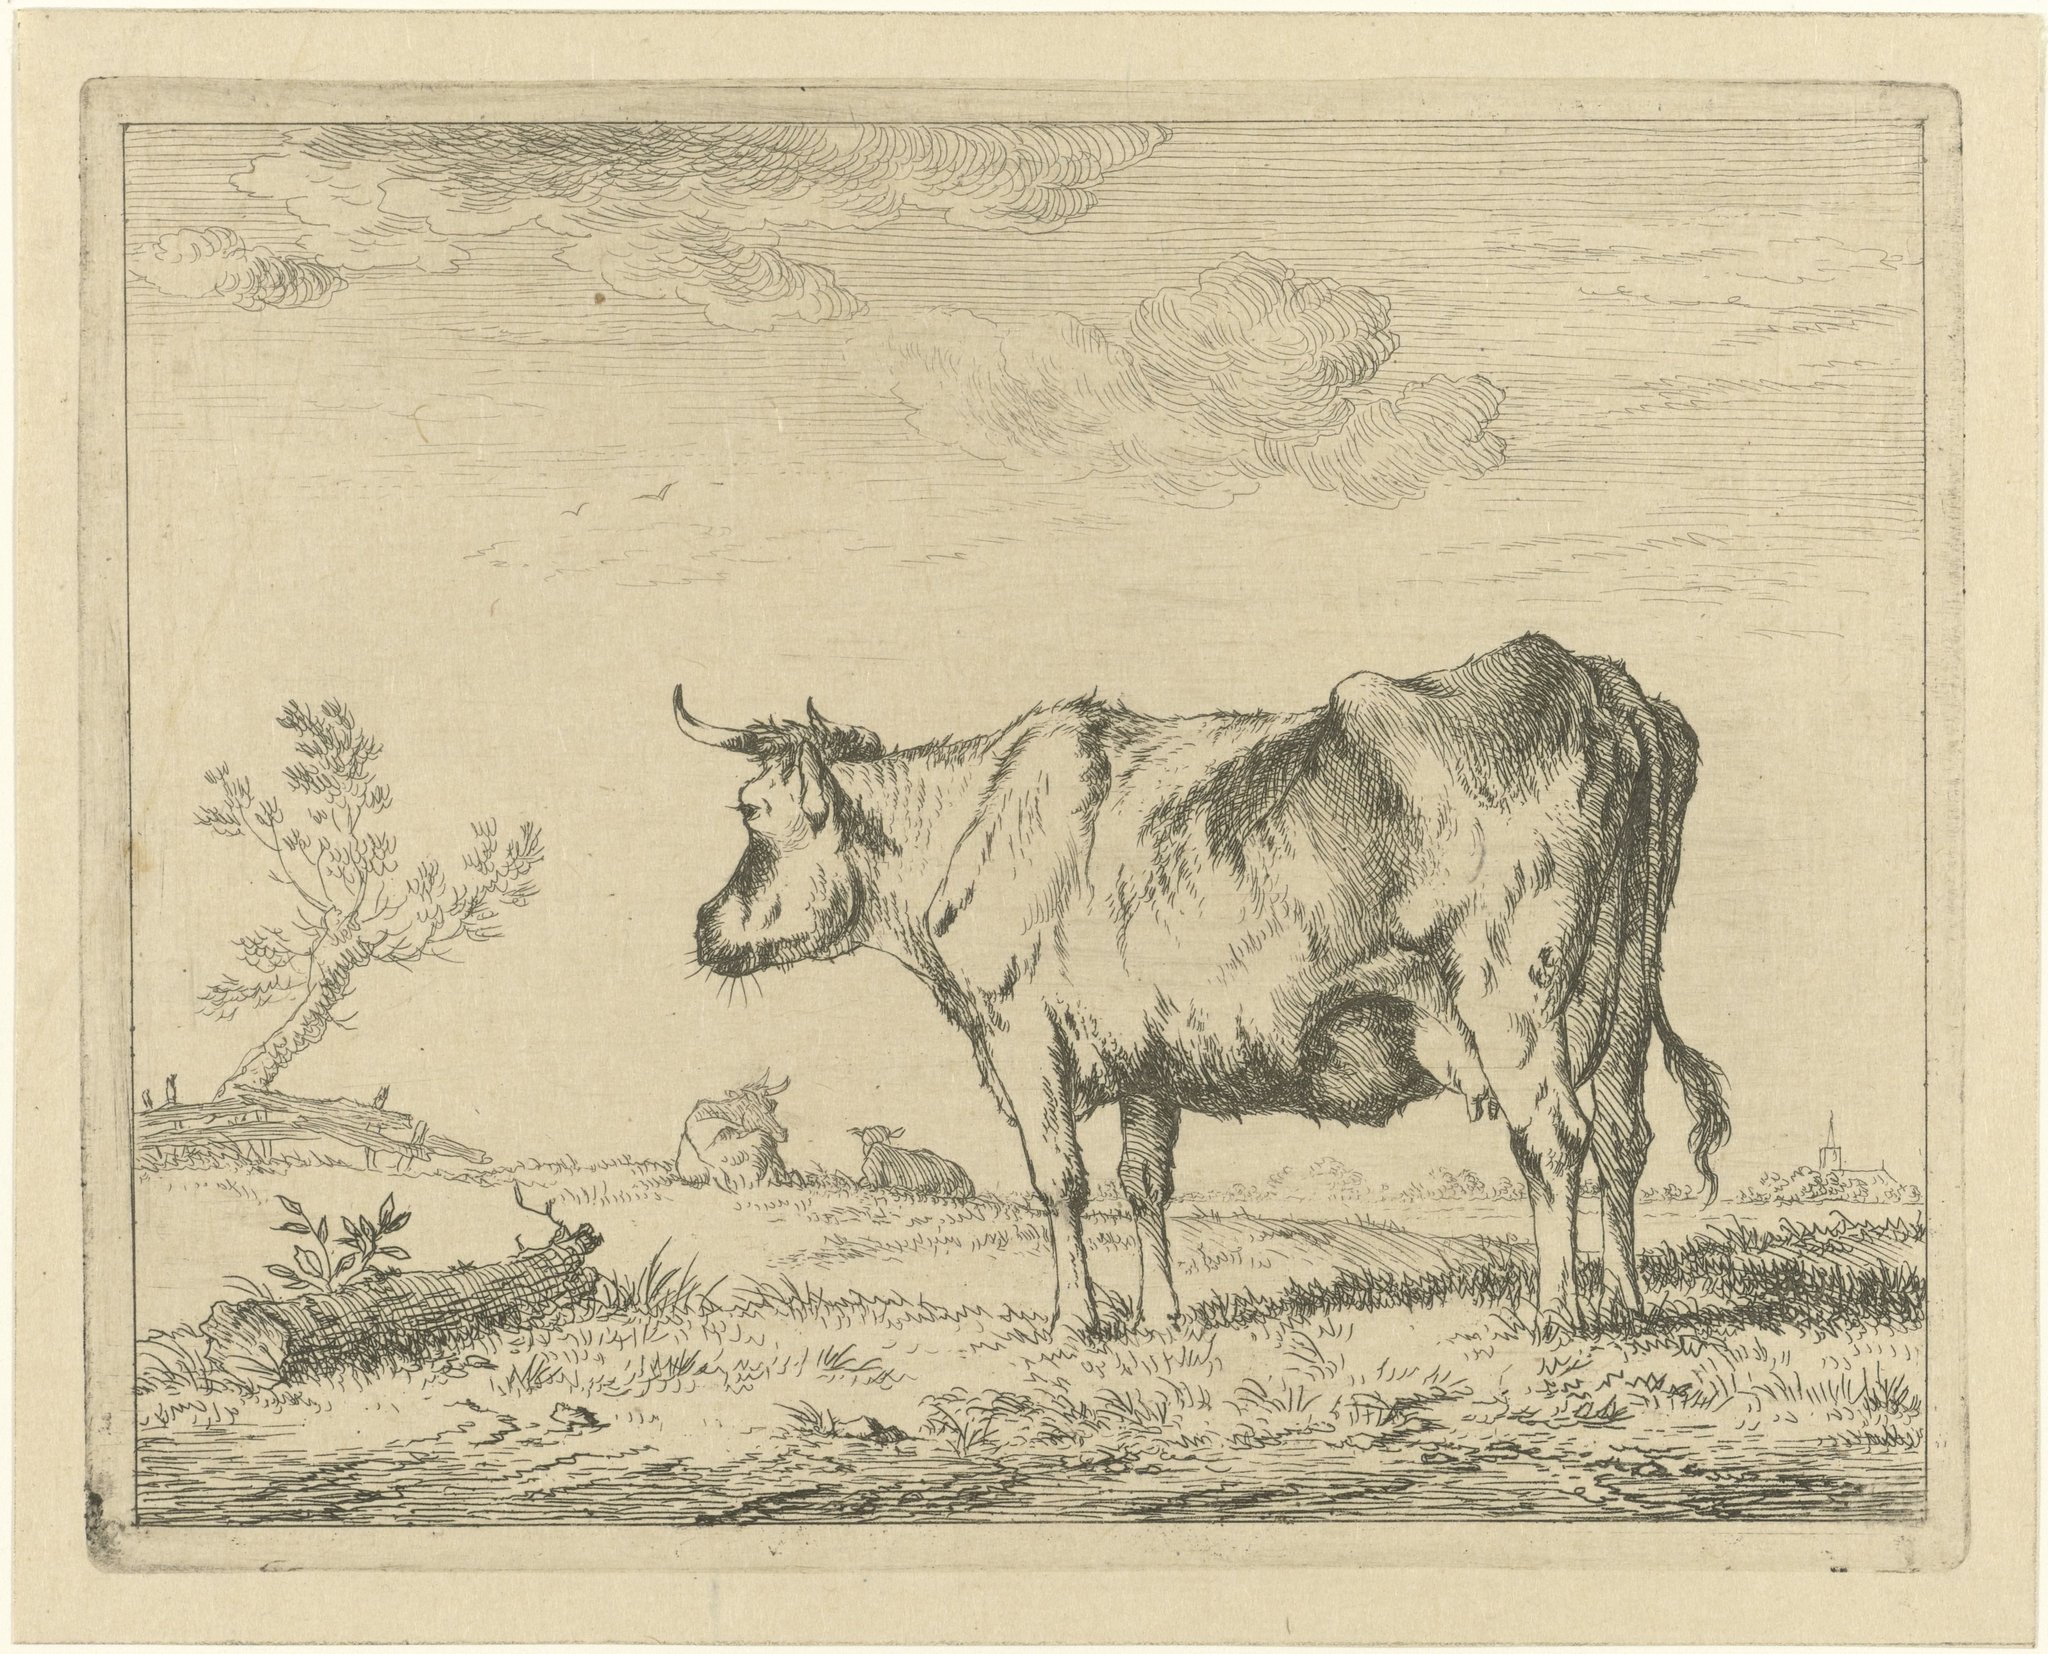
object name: print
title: Weiland met staande koe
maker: johannes janson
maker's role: draughtsman, painter, print maker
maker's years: 1729-1784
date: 1761-1784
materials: paper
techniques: etching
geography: leiden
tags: cow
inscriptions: collector's mark: Lugt 240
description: Weiland met staande koe, van opzij gezien. Op de achtergrond twee liggende koeien. Prent uit een serie met landschappen met vee.